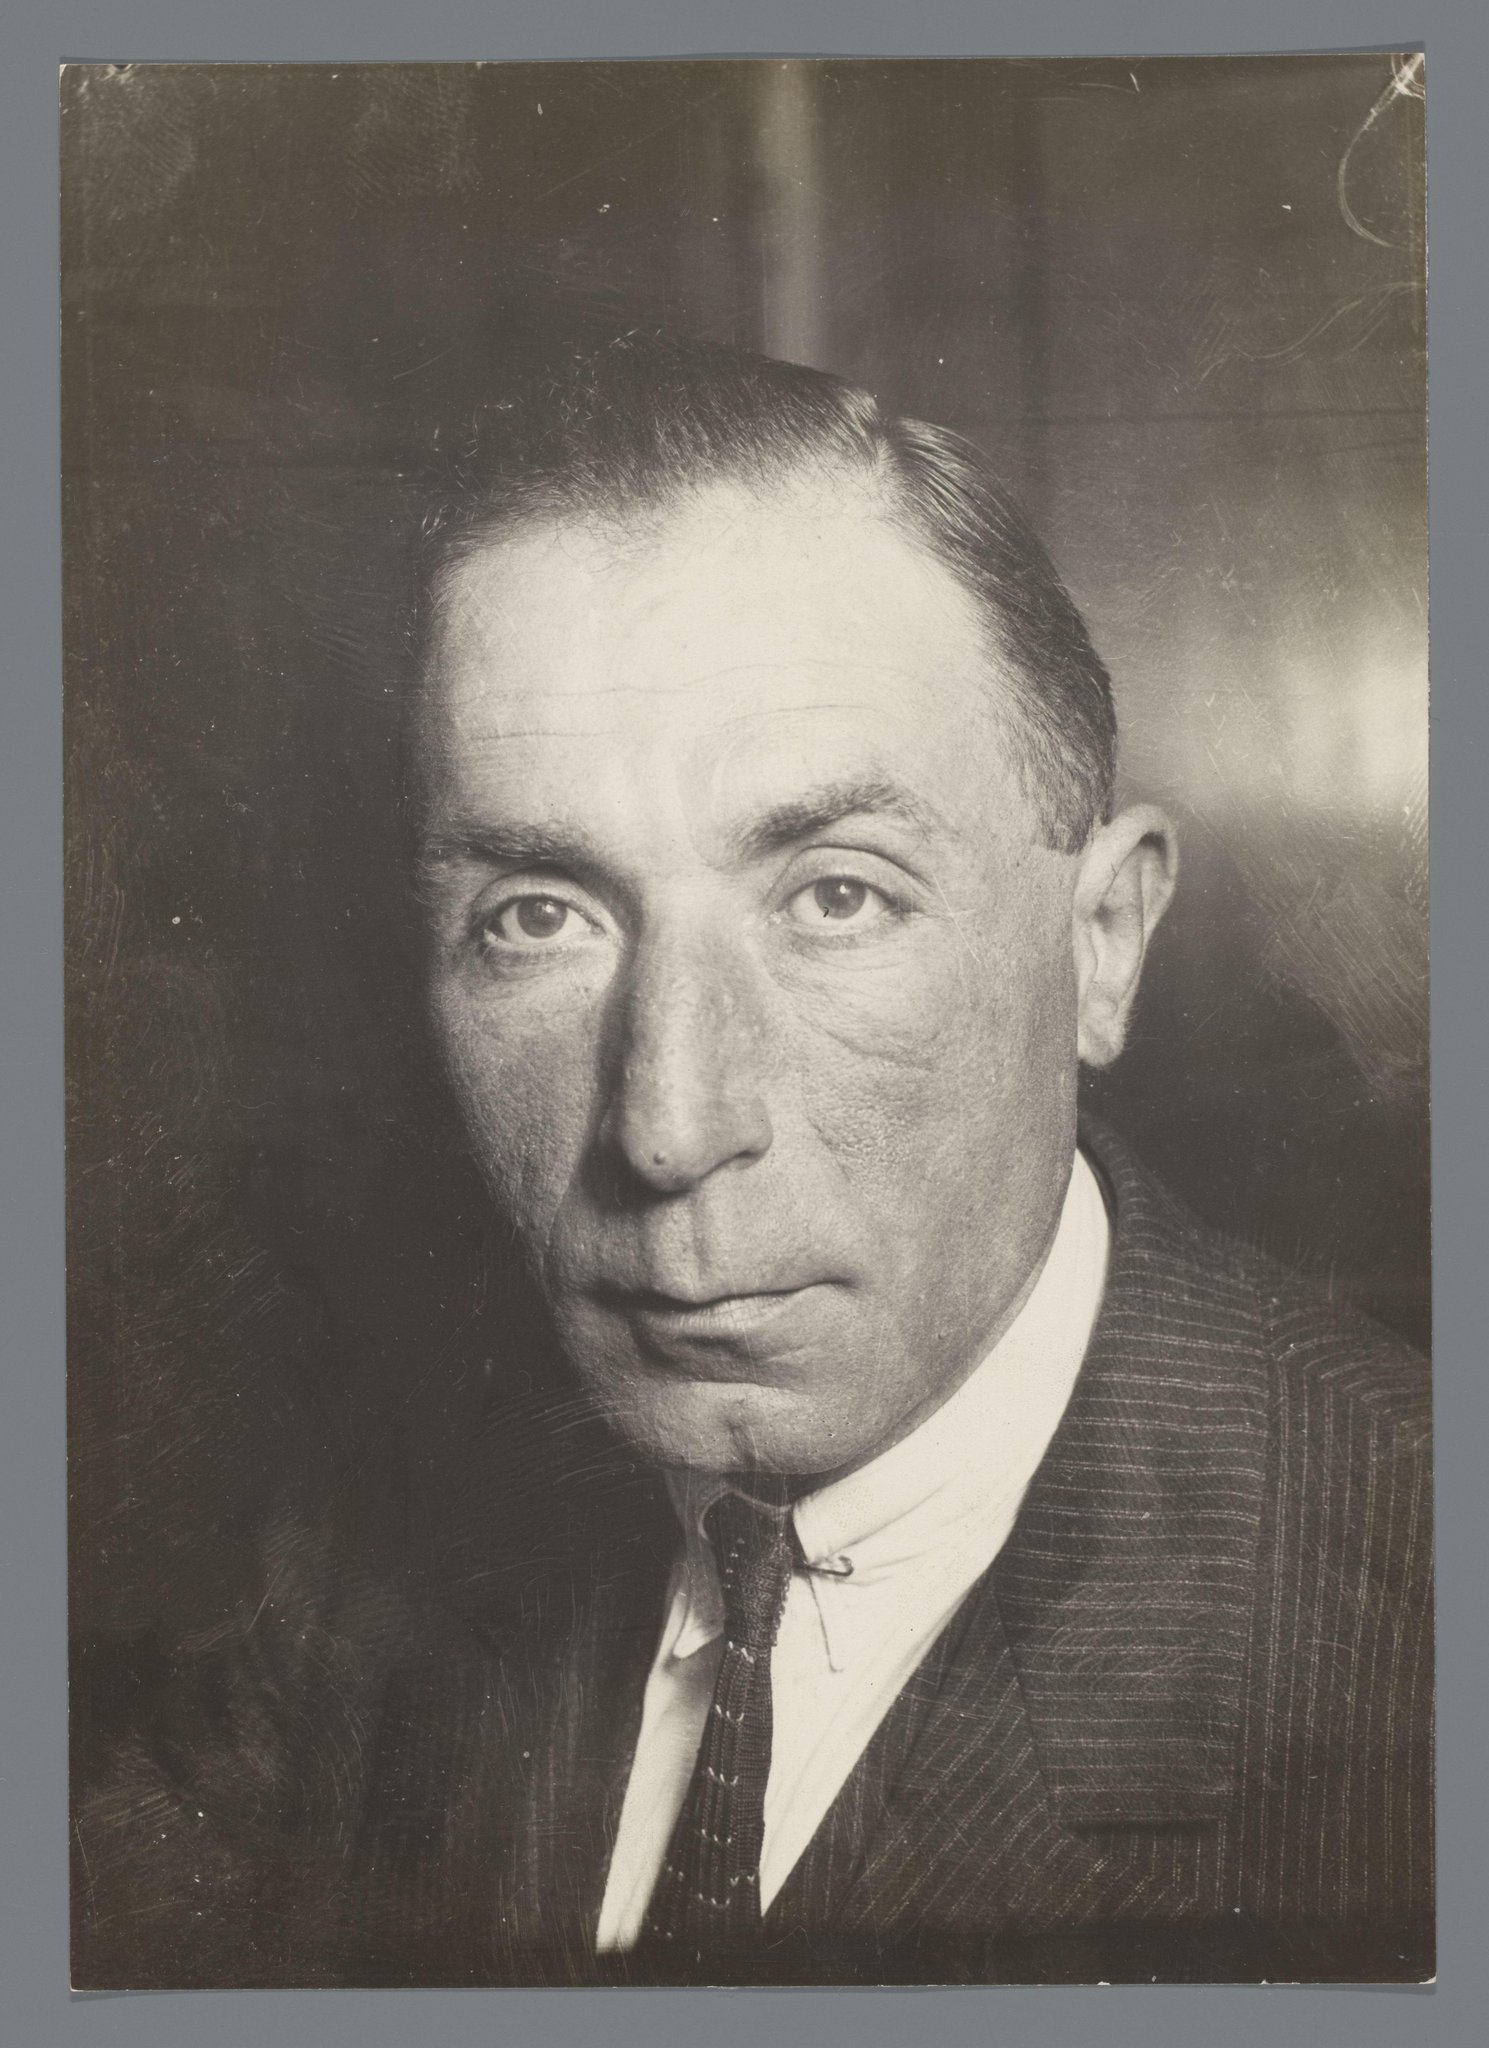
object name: photograph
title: Portret van Jerry Tarbot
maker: Anonymous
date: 1925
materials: paper, photographic support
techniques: gelatin silver print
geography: united states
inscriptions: annotation: ‘Jerry Talbot His real name is a mystery Amnesia’, annotation: ‘17 3295’, stamp: ‘REFERENCE DEPT. OCT 7 1925 N.E.A.’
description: Tarbots echte naam was een mysterie: hij leed aan geheugenverlies door toedoen van shell shock. Later werd hij aangeklaagd: hij zou zijn geheugenverlies hebben geveinsd en in werkelijkheid een vervalser, deserteur en autodief zijn. ('faker', 'draft dodger' and 'automobile thief')